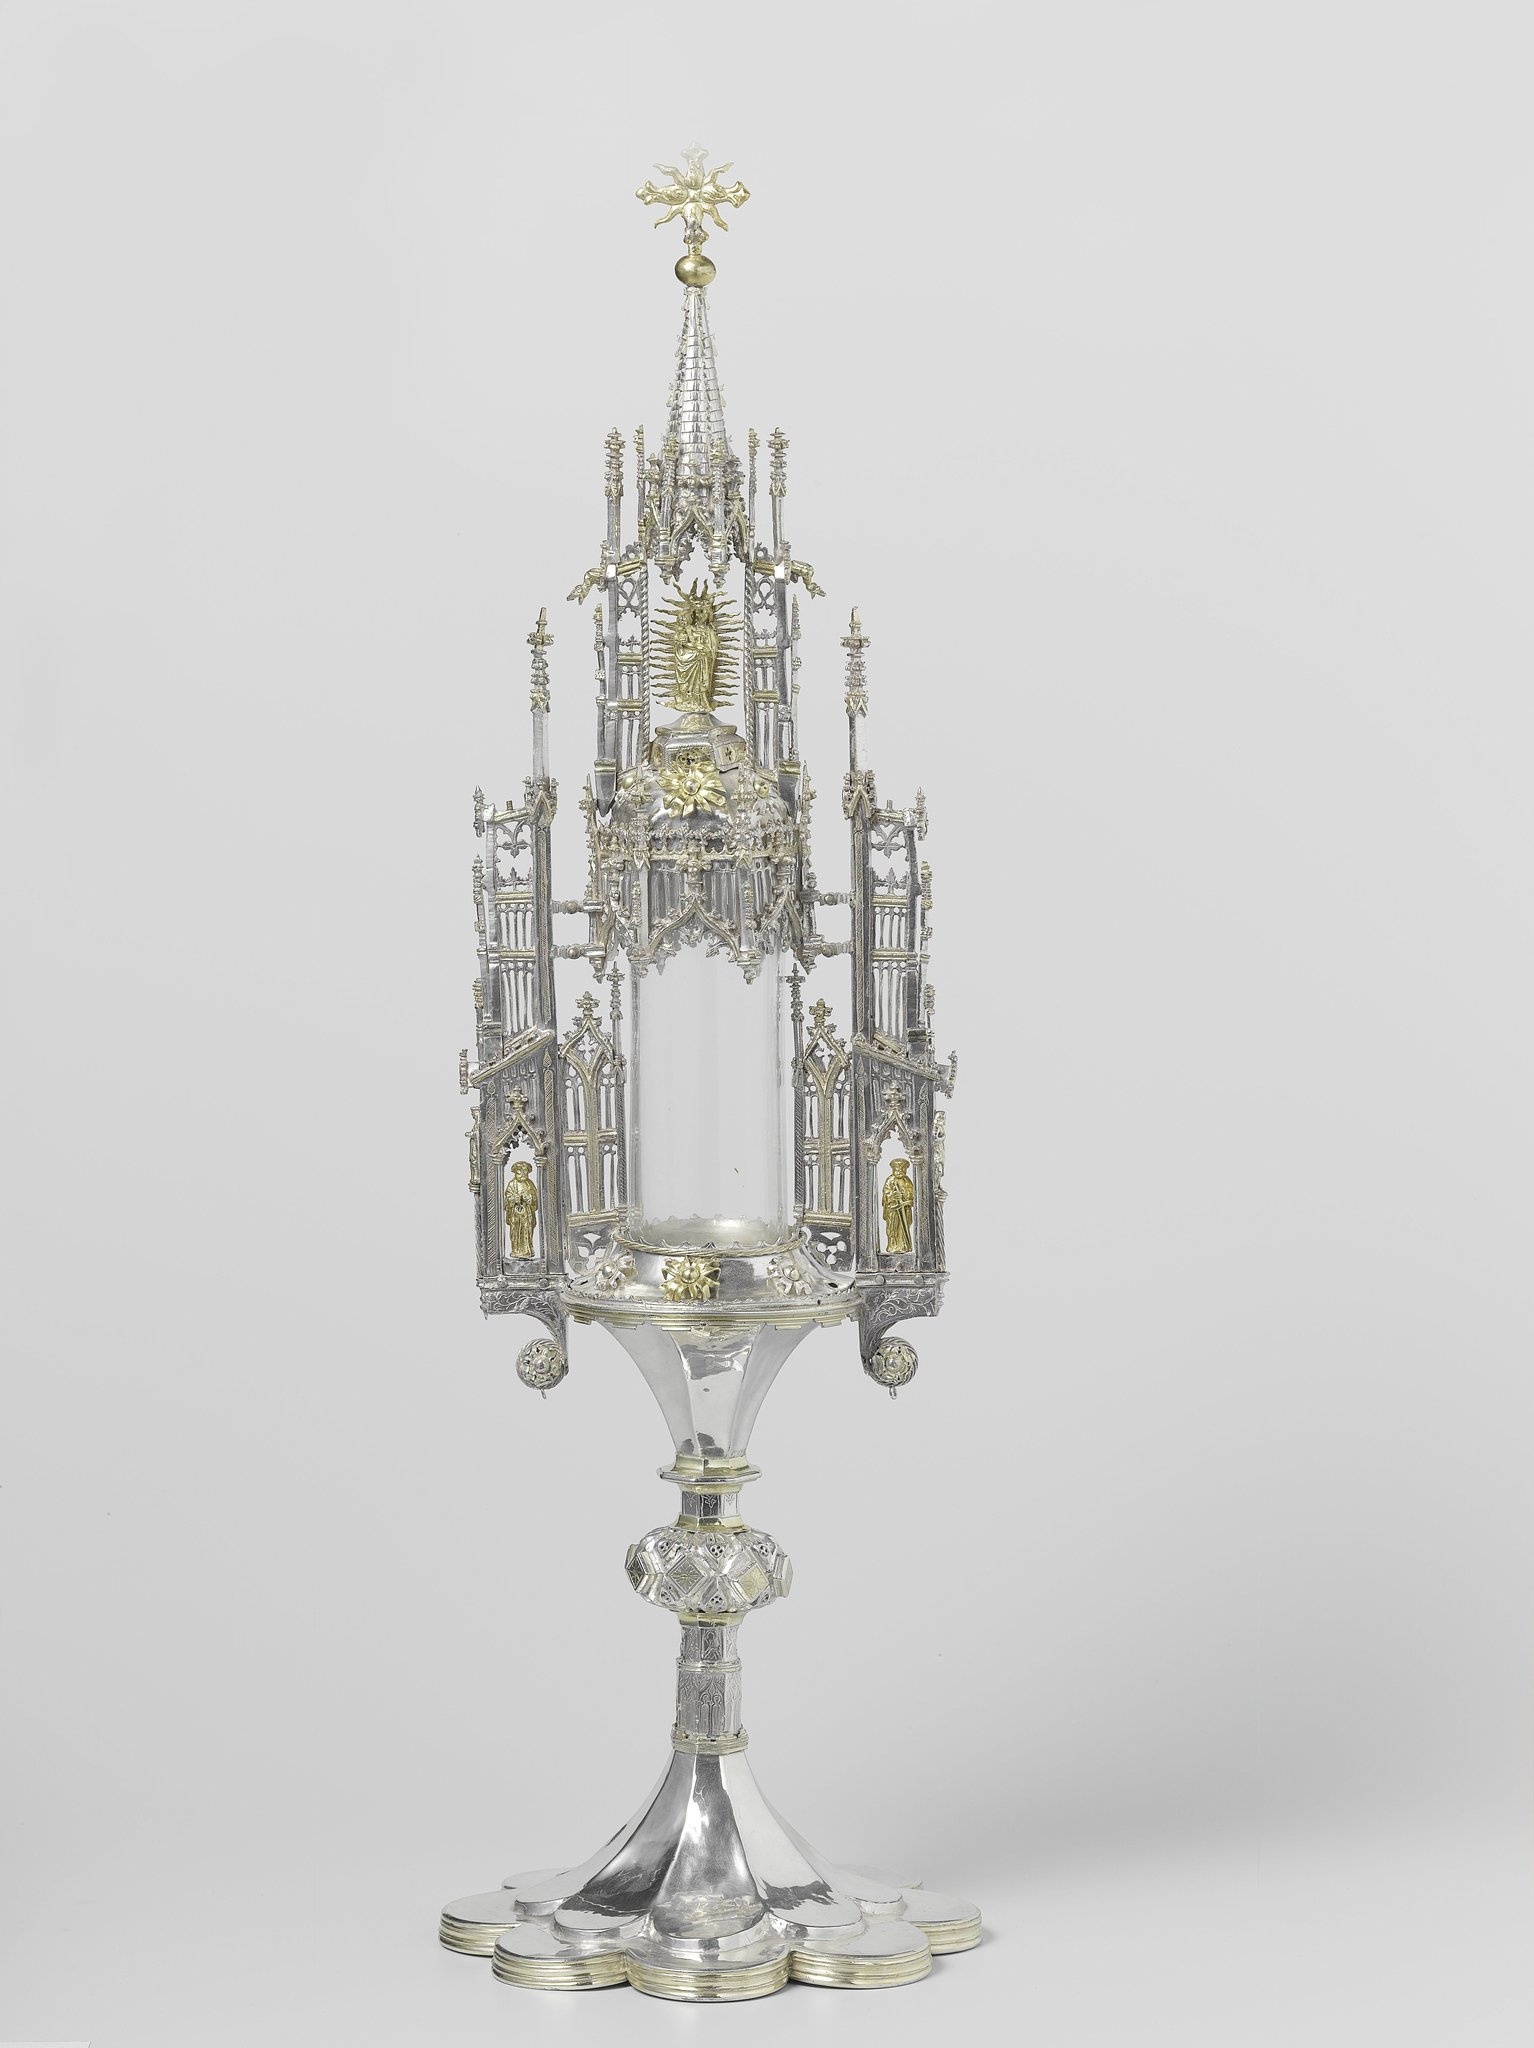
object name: monstrans, ostensorium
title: Monstrance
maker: jan geldolfs hoghenzoon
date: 1520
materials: glass, silver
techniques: gilding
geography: breda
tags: 'marianum', madonna in aureole or mandorla (surrounded by the rosary), mary in the glory, the apostle peter, first bishop of rome; possible attributes: book, cock, (upturned) cross, (triple) crozier, fish, key, scroll, ship, tiara, the apostle paul of tarsus; possible attributes: book, scroll, sword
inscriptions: town mark, maker's mark: ‘G’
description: The design of monstrances closely reflected the elaborate Gothic church architecture of the 15th and early 16th centuries. The glass section was for the host, the body of Christ, according to Roman Catholic doctrine. This sacred host was displayed in a monstrance to worshippers during processions and on religious feast days.